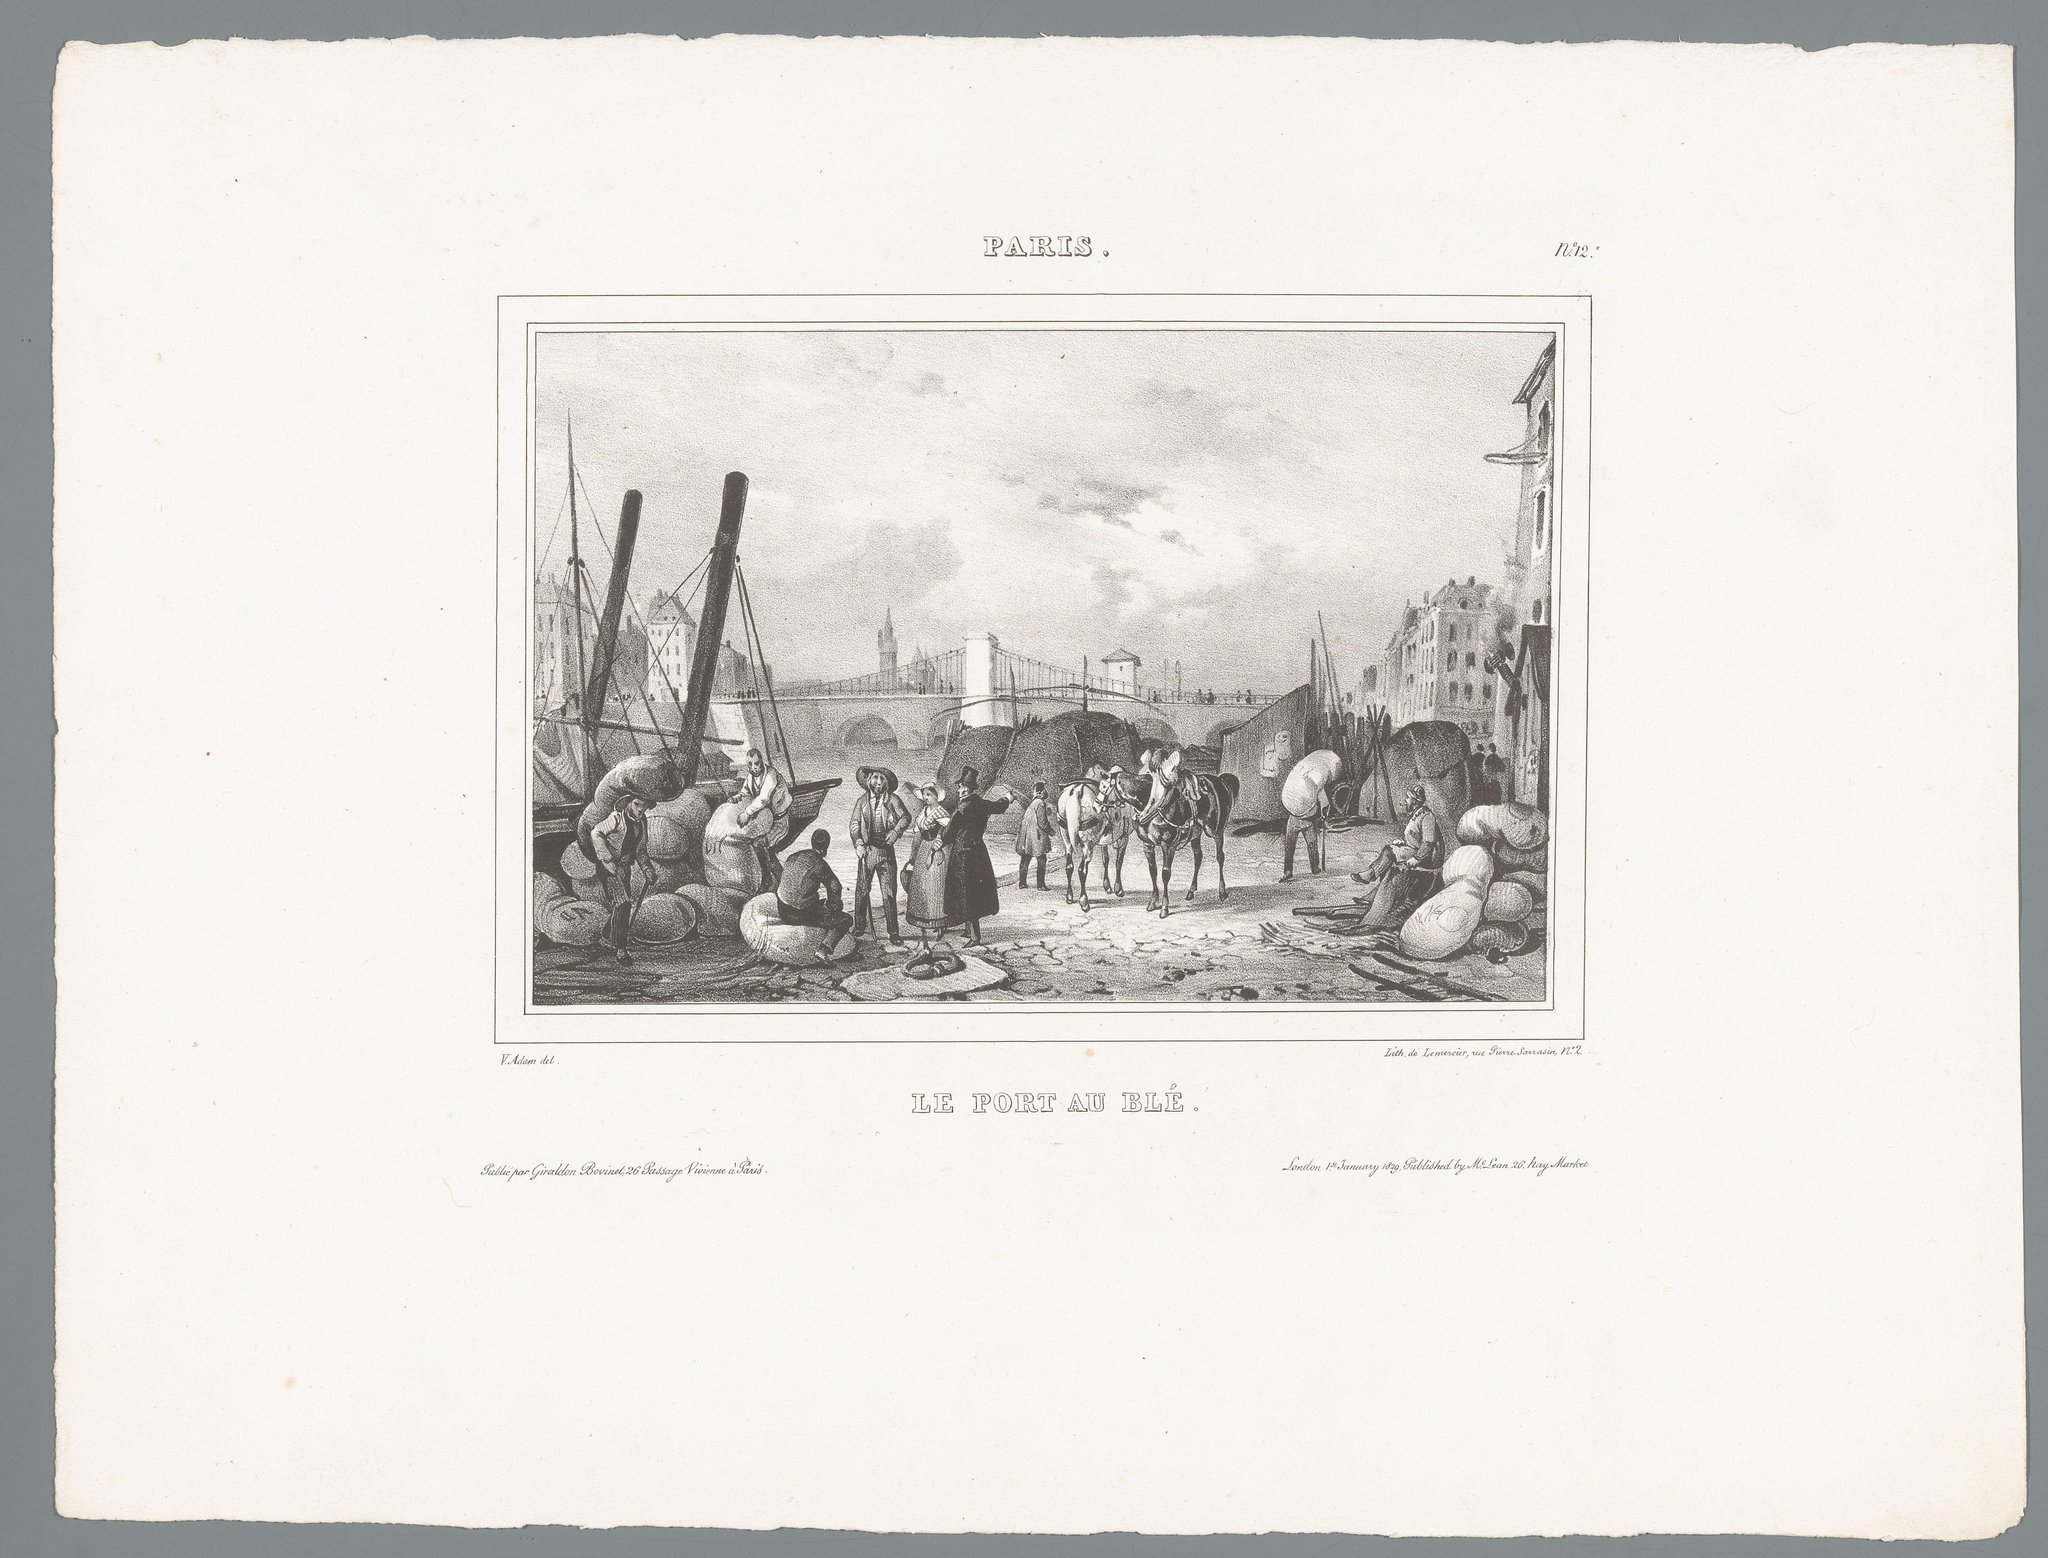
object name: print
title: Paris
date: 1829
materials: paper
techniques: lithograph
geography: paris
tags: harbour, river, merchant shipping, shipping trade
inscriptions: collector's mark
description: Een graanschip wordt gelost in de haven van Blé aan de Seine in Parijs.